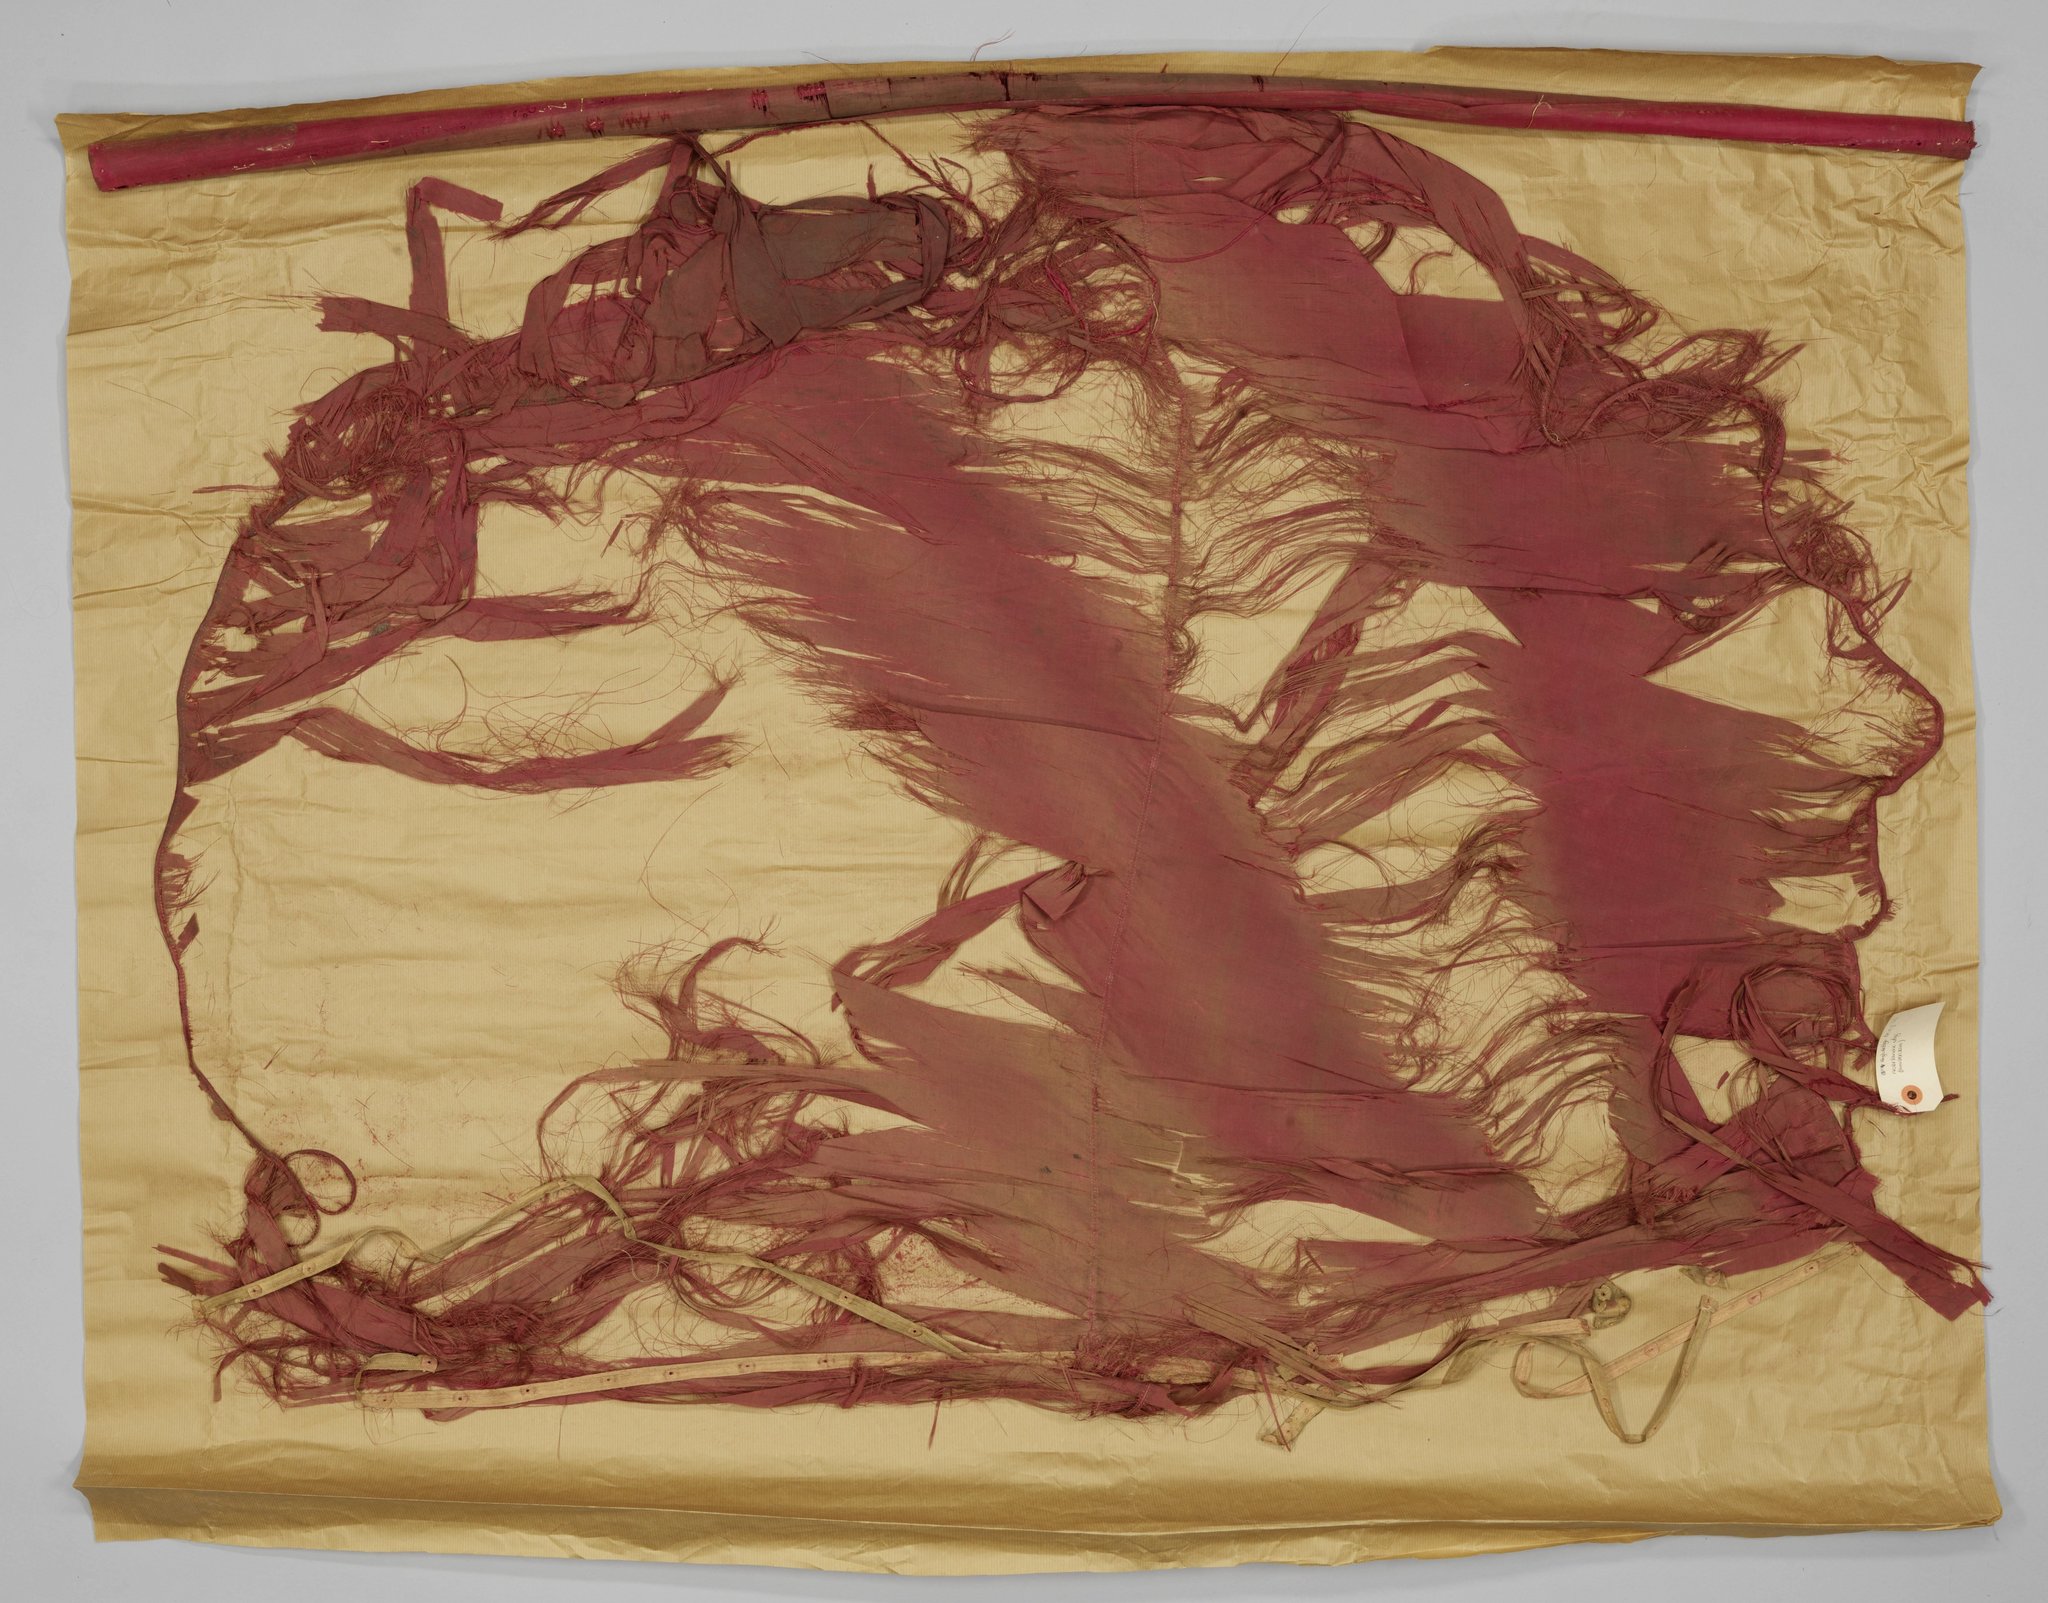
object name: banner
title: Vaandel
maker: Anonymous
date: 1700-1800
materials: paint, silk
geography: amsterdam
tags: amsterdam